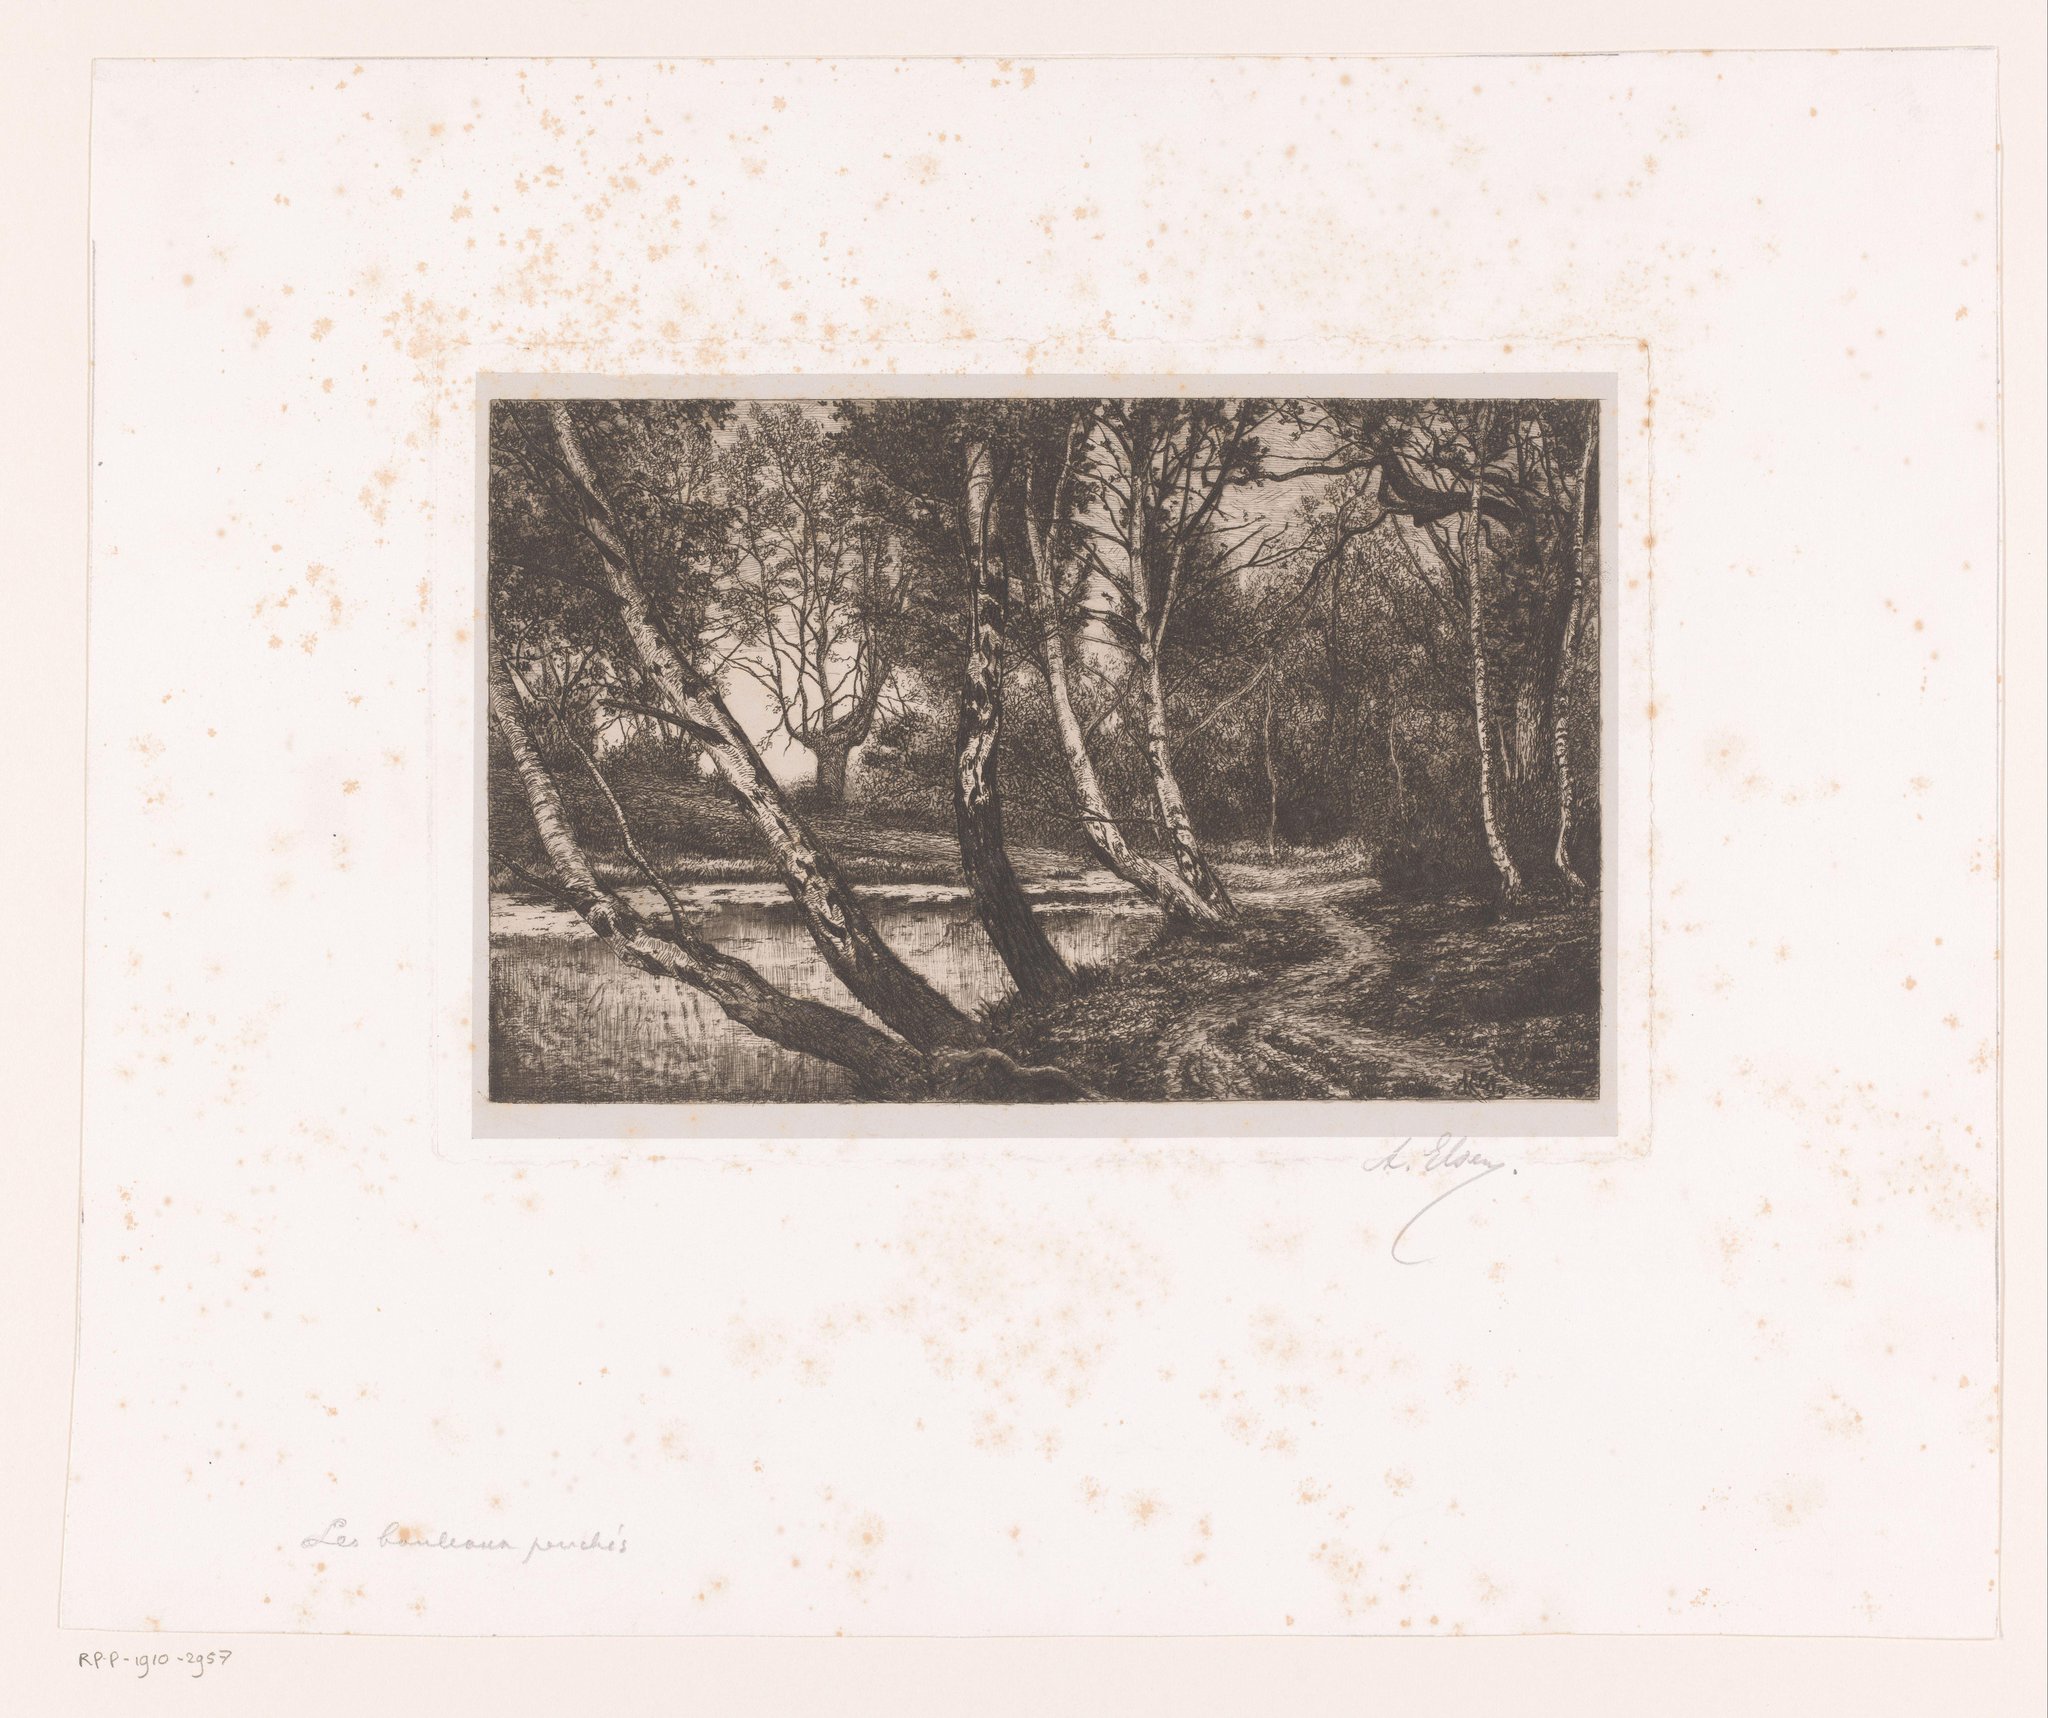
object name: print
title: Landschap met berken langs een oever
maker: alfred elsen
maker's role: painter, print maker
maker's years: 1850-1914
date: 1860-1910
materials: paper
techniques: etching, intaglio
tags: lake, forest path or lane, trees: birch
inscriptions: collector's mark: Lugt 2228